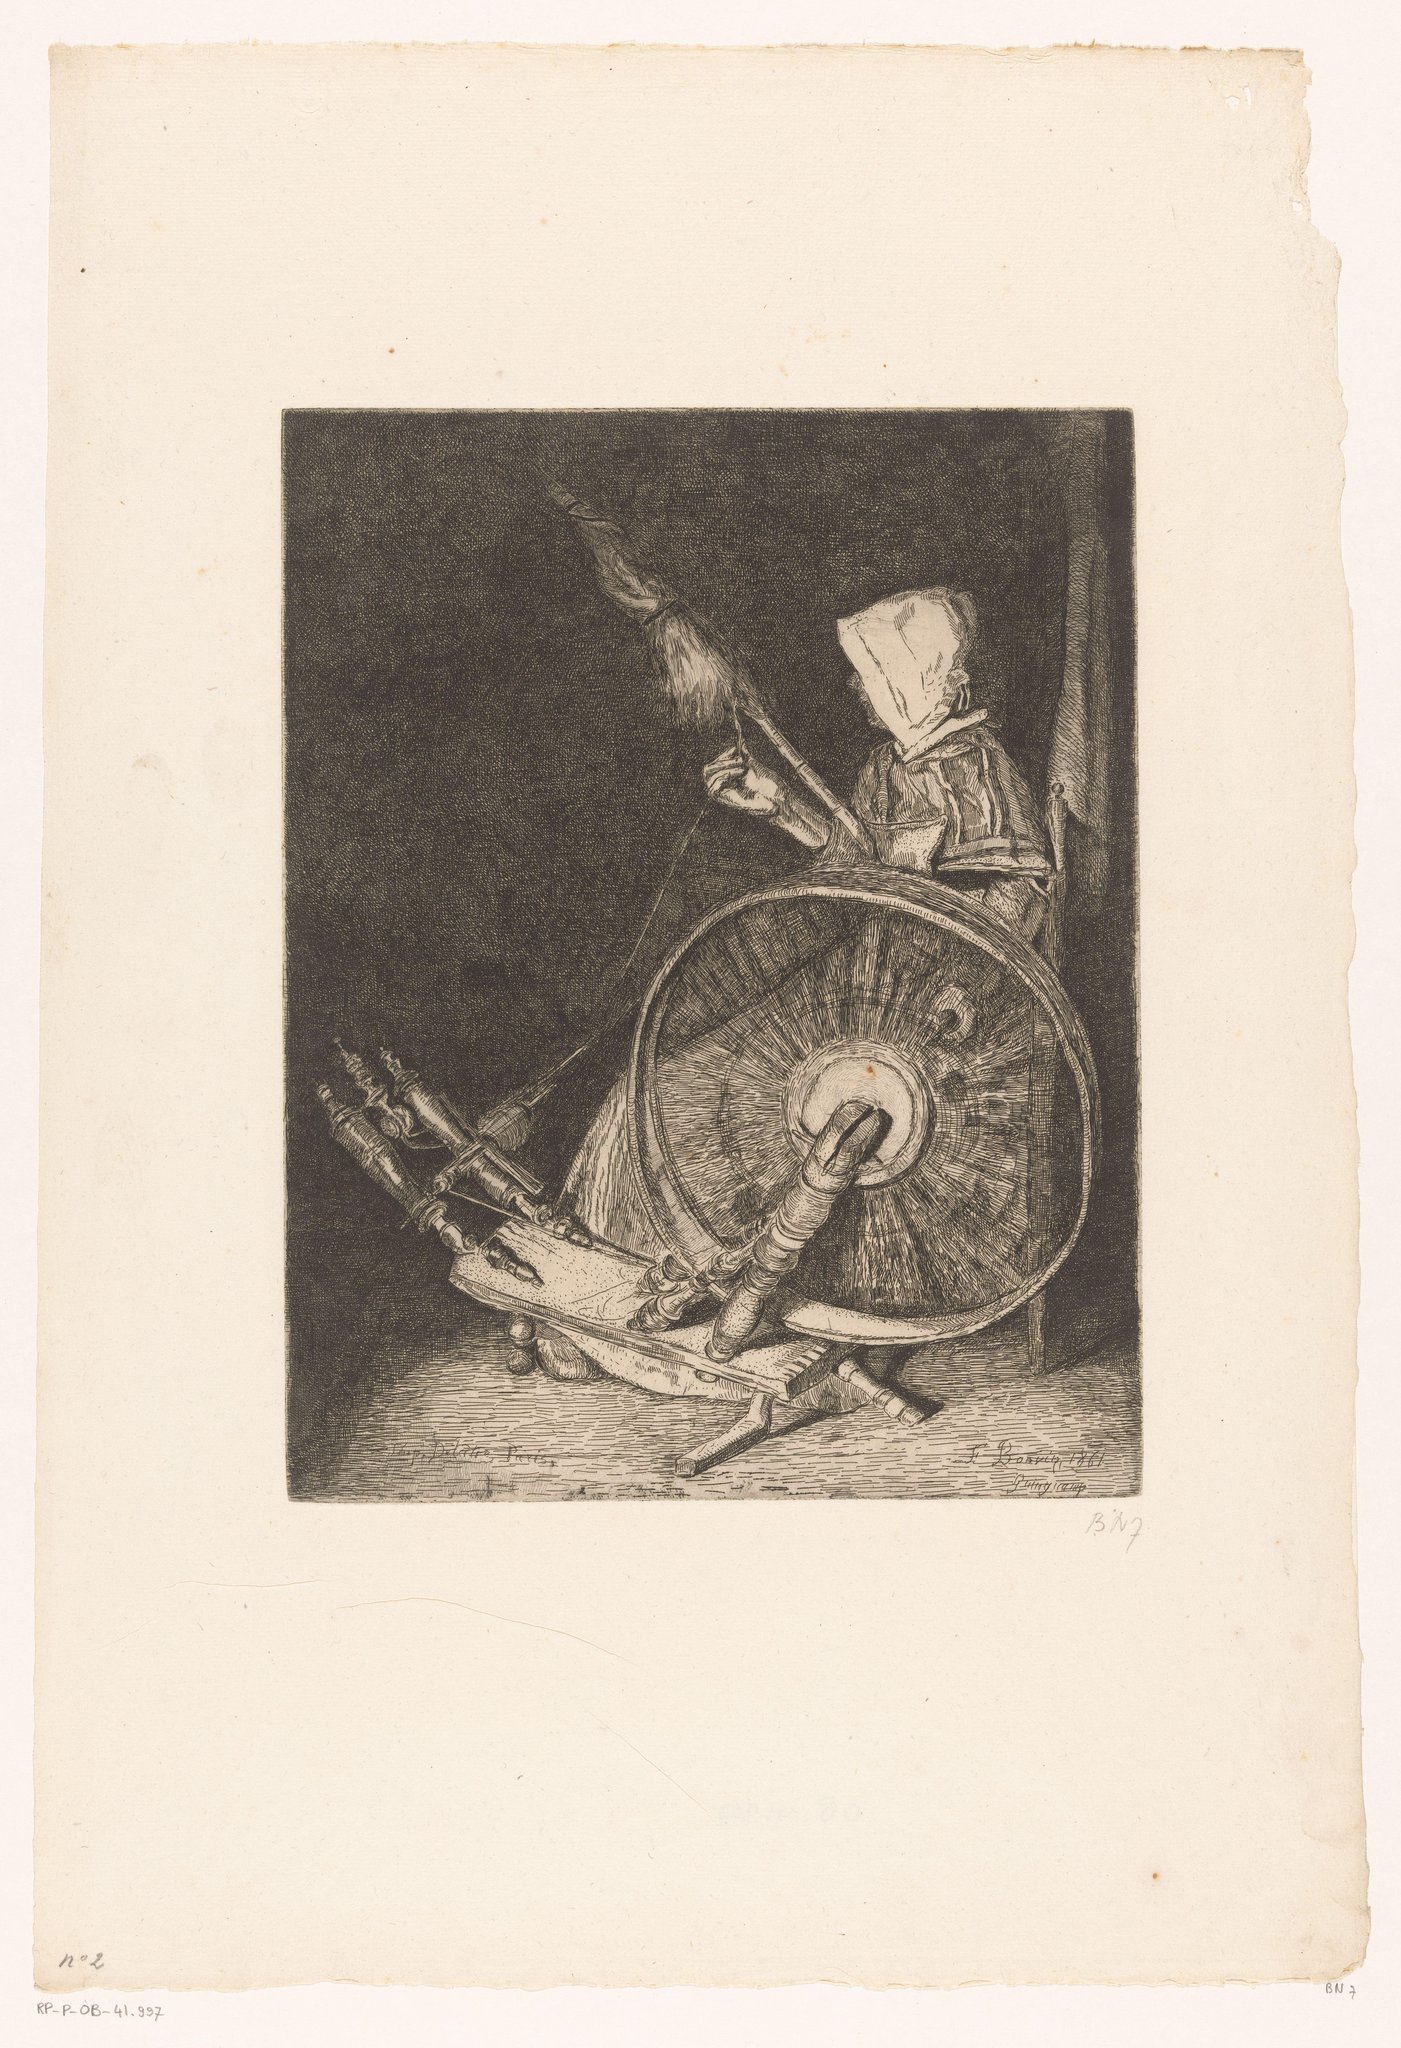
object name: print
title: Bretonse spinster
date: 1861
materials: paper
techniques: etching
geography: paris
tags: distaff, spinning-wheel, spindle, spinning (manufacture of yarn)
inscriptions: collector's mark: Lugt 2228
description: Maakt deel uit van een zesdelige serie, getiteld: Six Eaux-fortes, dessinées et gravées par F. Bonvin, Peintre. De eerste staat werd in 1861 door Bonvin uitgegeven in Parijs.